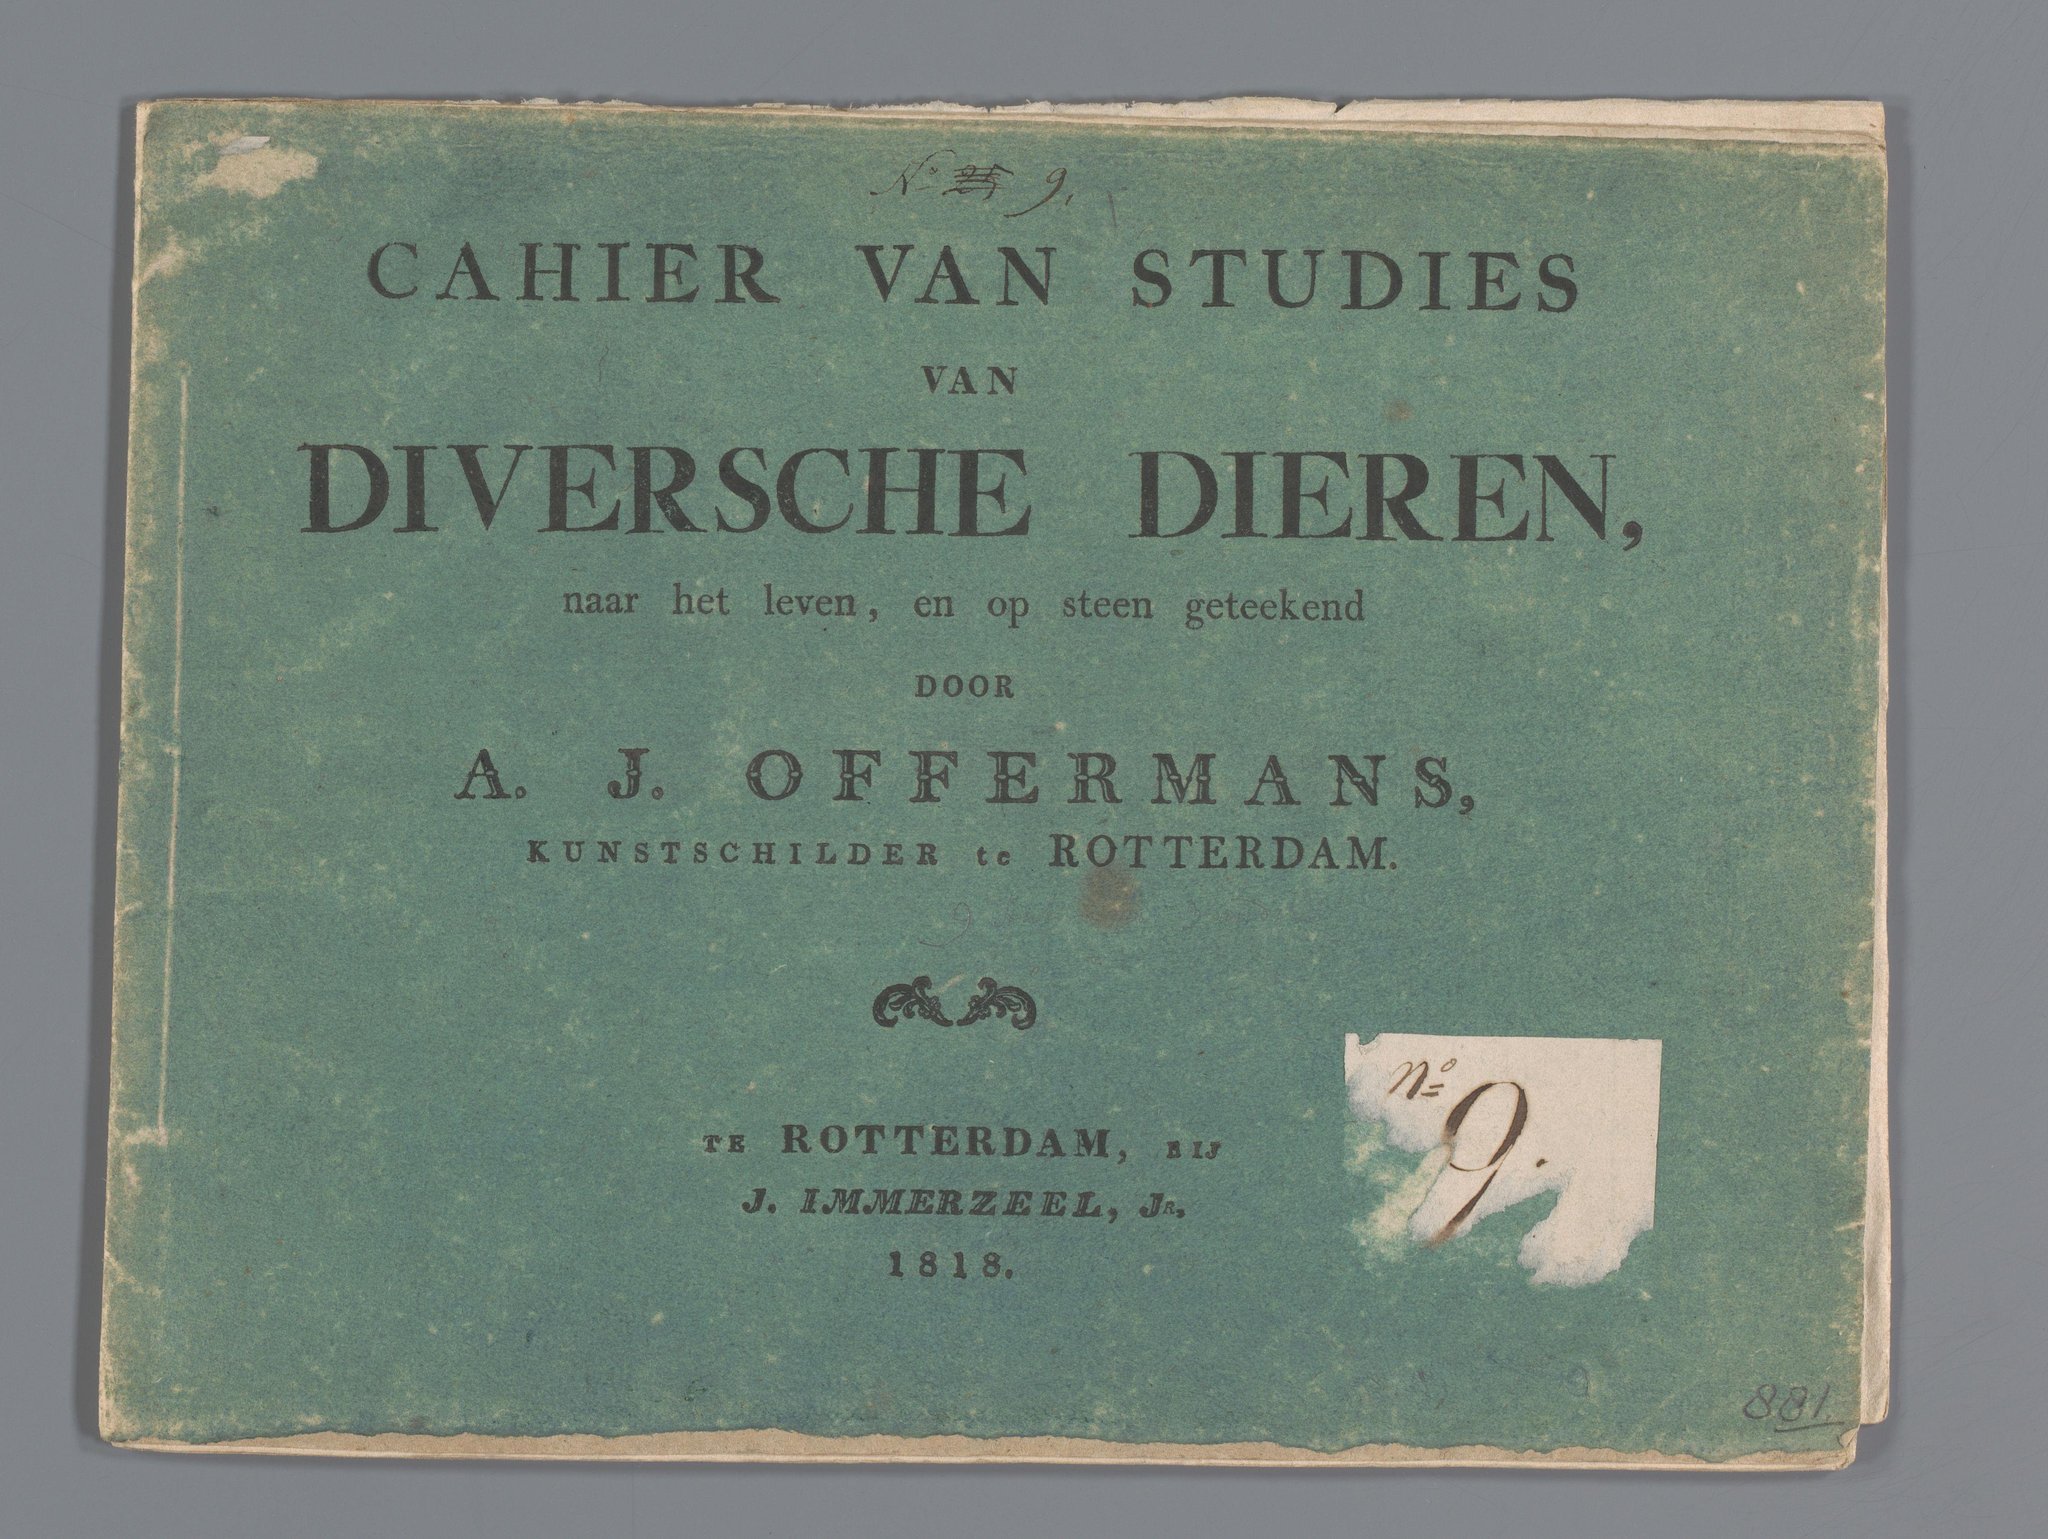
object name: prentrecueil, prentenalbum, prentalbum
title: Cahier van studies van diversche dieren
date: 1818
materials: paper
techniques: letterpress printing, lithograph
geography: rotterdam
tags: animals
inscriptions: date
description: Prentalbum met een serie van acht dierstudies van Anthony Jacobus Offermans. Schrift met groene omslag waarin lithografieën gebonden.